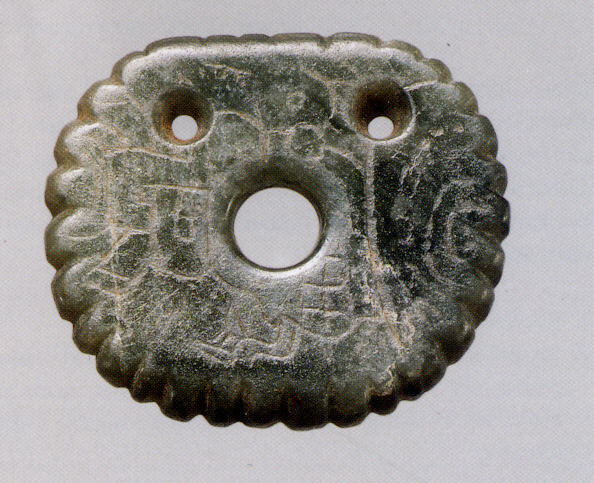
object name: ornament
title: Ornament with Maya glyph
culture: atlantic watershed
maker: maya and atlantic watershed artists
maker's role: artist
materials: jade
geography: costa rica